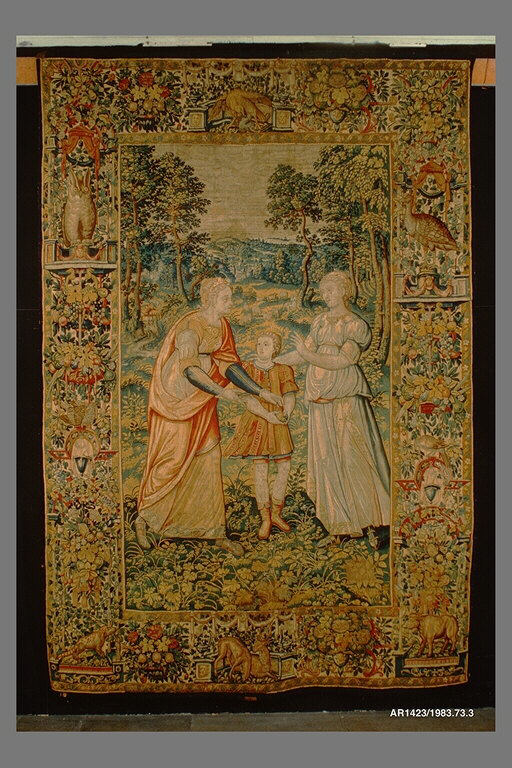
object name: tapestry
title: Rachel and Bilhah with Dan from The Story of Jacob series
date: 1550-1575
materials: silk, wool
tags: men,women,owls